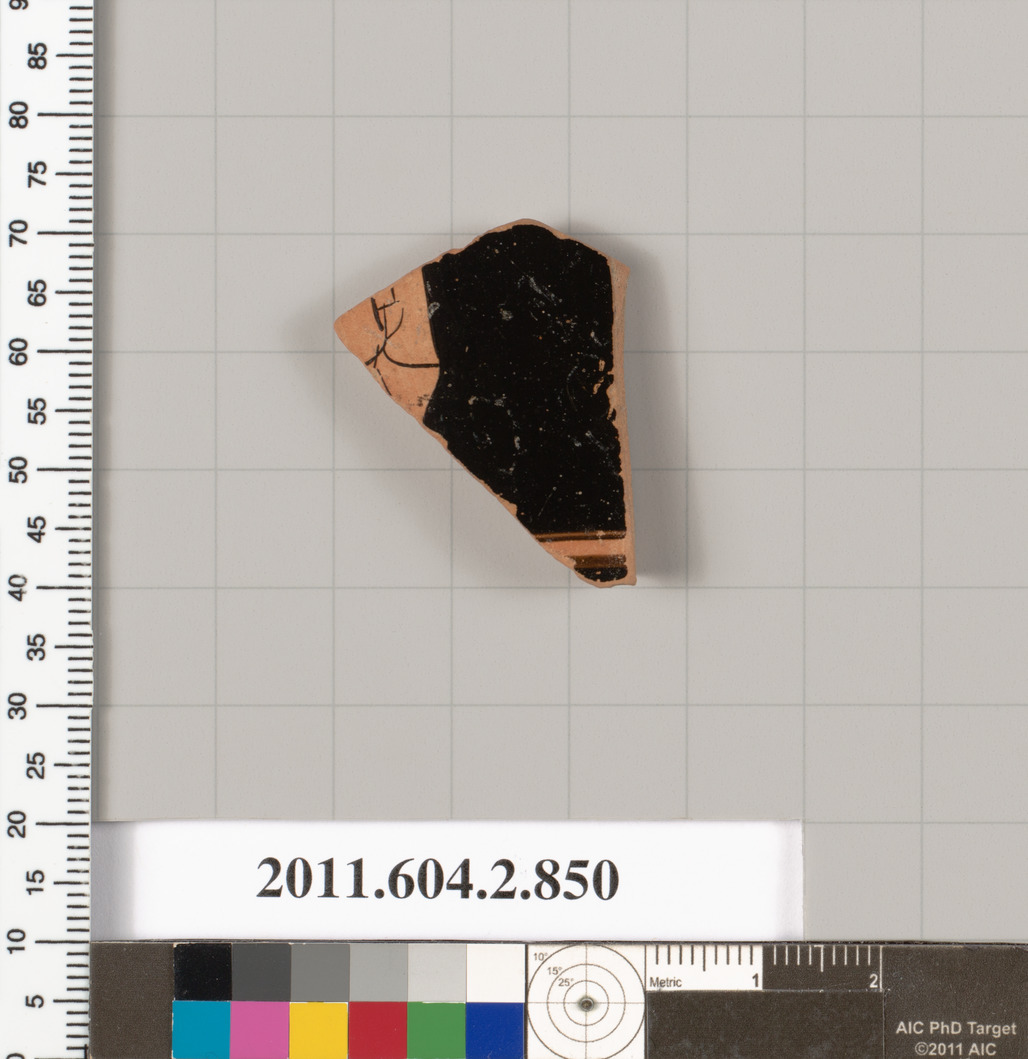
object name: bell krater fragment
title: Terracotta fragment of a bell-krater (bowl for mixing wine and water)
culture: greek, attic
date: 450-440 BCE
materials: terracotta